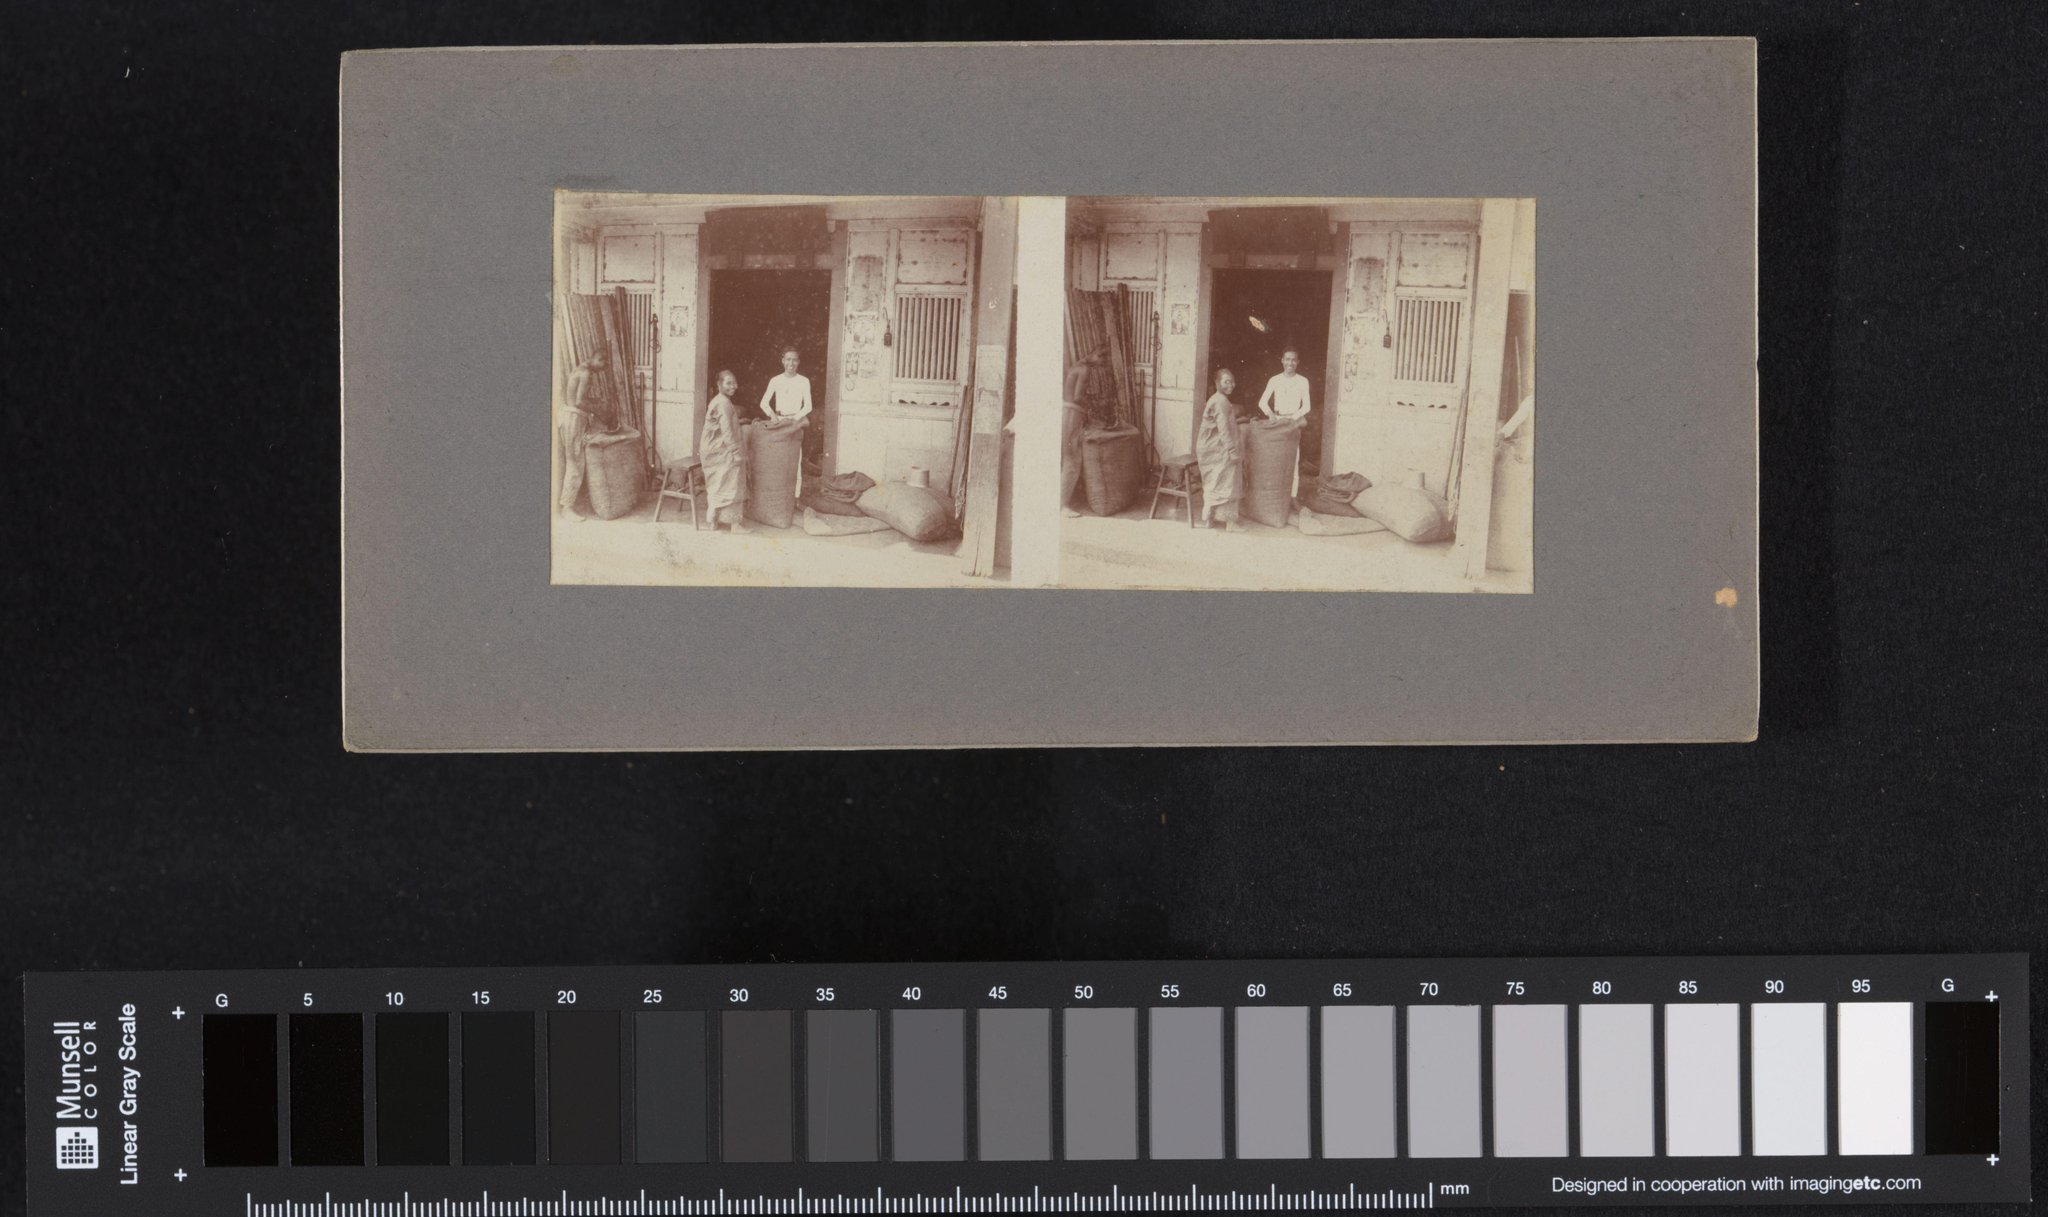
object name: stereograph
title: Man en vrouw voor winkel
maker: robert julius boers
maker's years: 1867-1932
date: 1900-1922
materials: cardboard, photographic support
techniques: gelatin silver print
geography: bangka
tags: robert julius boers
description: Indische man en vrouw bij het dichtbinden van een grote zak voor een winkel of magazijn te Soengeiliat op Banka. Onderdeel van een groep stereofoto's van Robert Julius Boers, chef van het staatsbedrijf de Banka-tinwinning op Banka, uit de periode ca. 1900-1922.